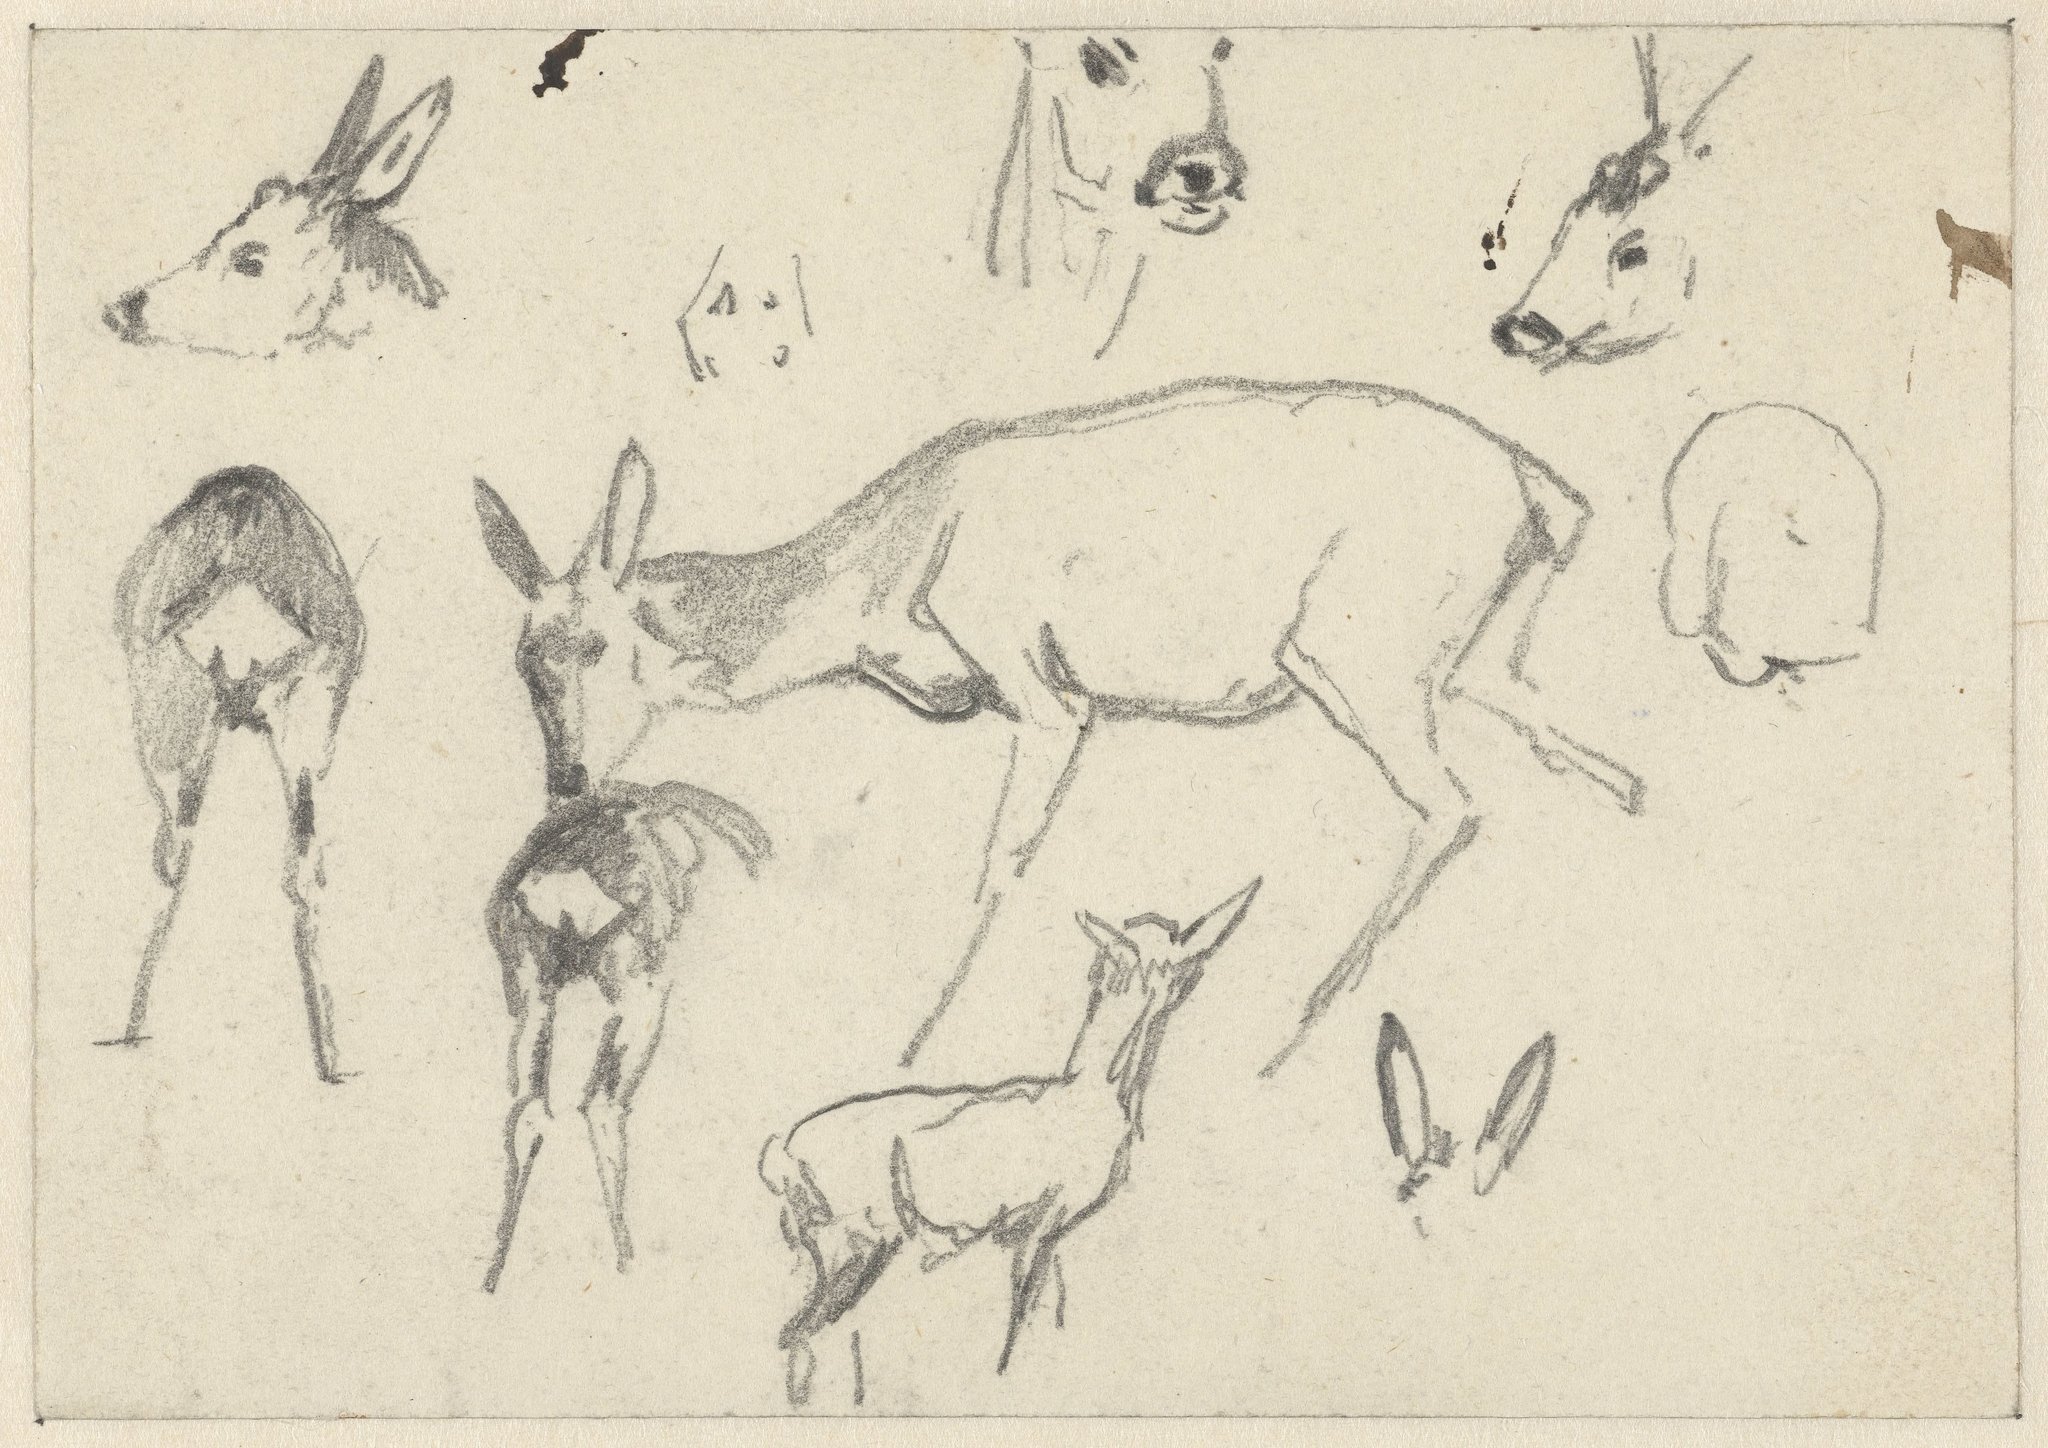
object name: drawing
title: Studieblad met herten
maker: guillaume anne van der brugghen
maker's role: draughtsman, print maker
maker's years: 1812-1891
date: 1821-1891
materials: paper, pencil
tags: hoofed animals: deer